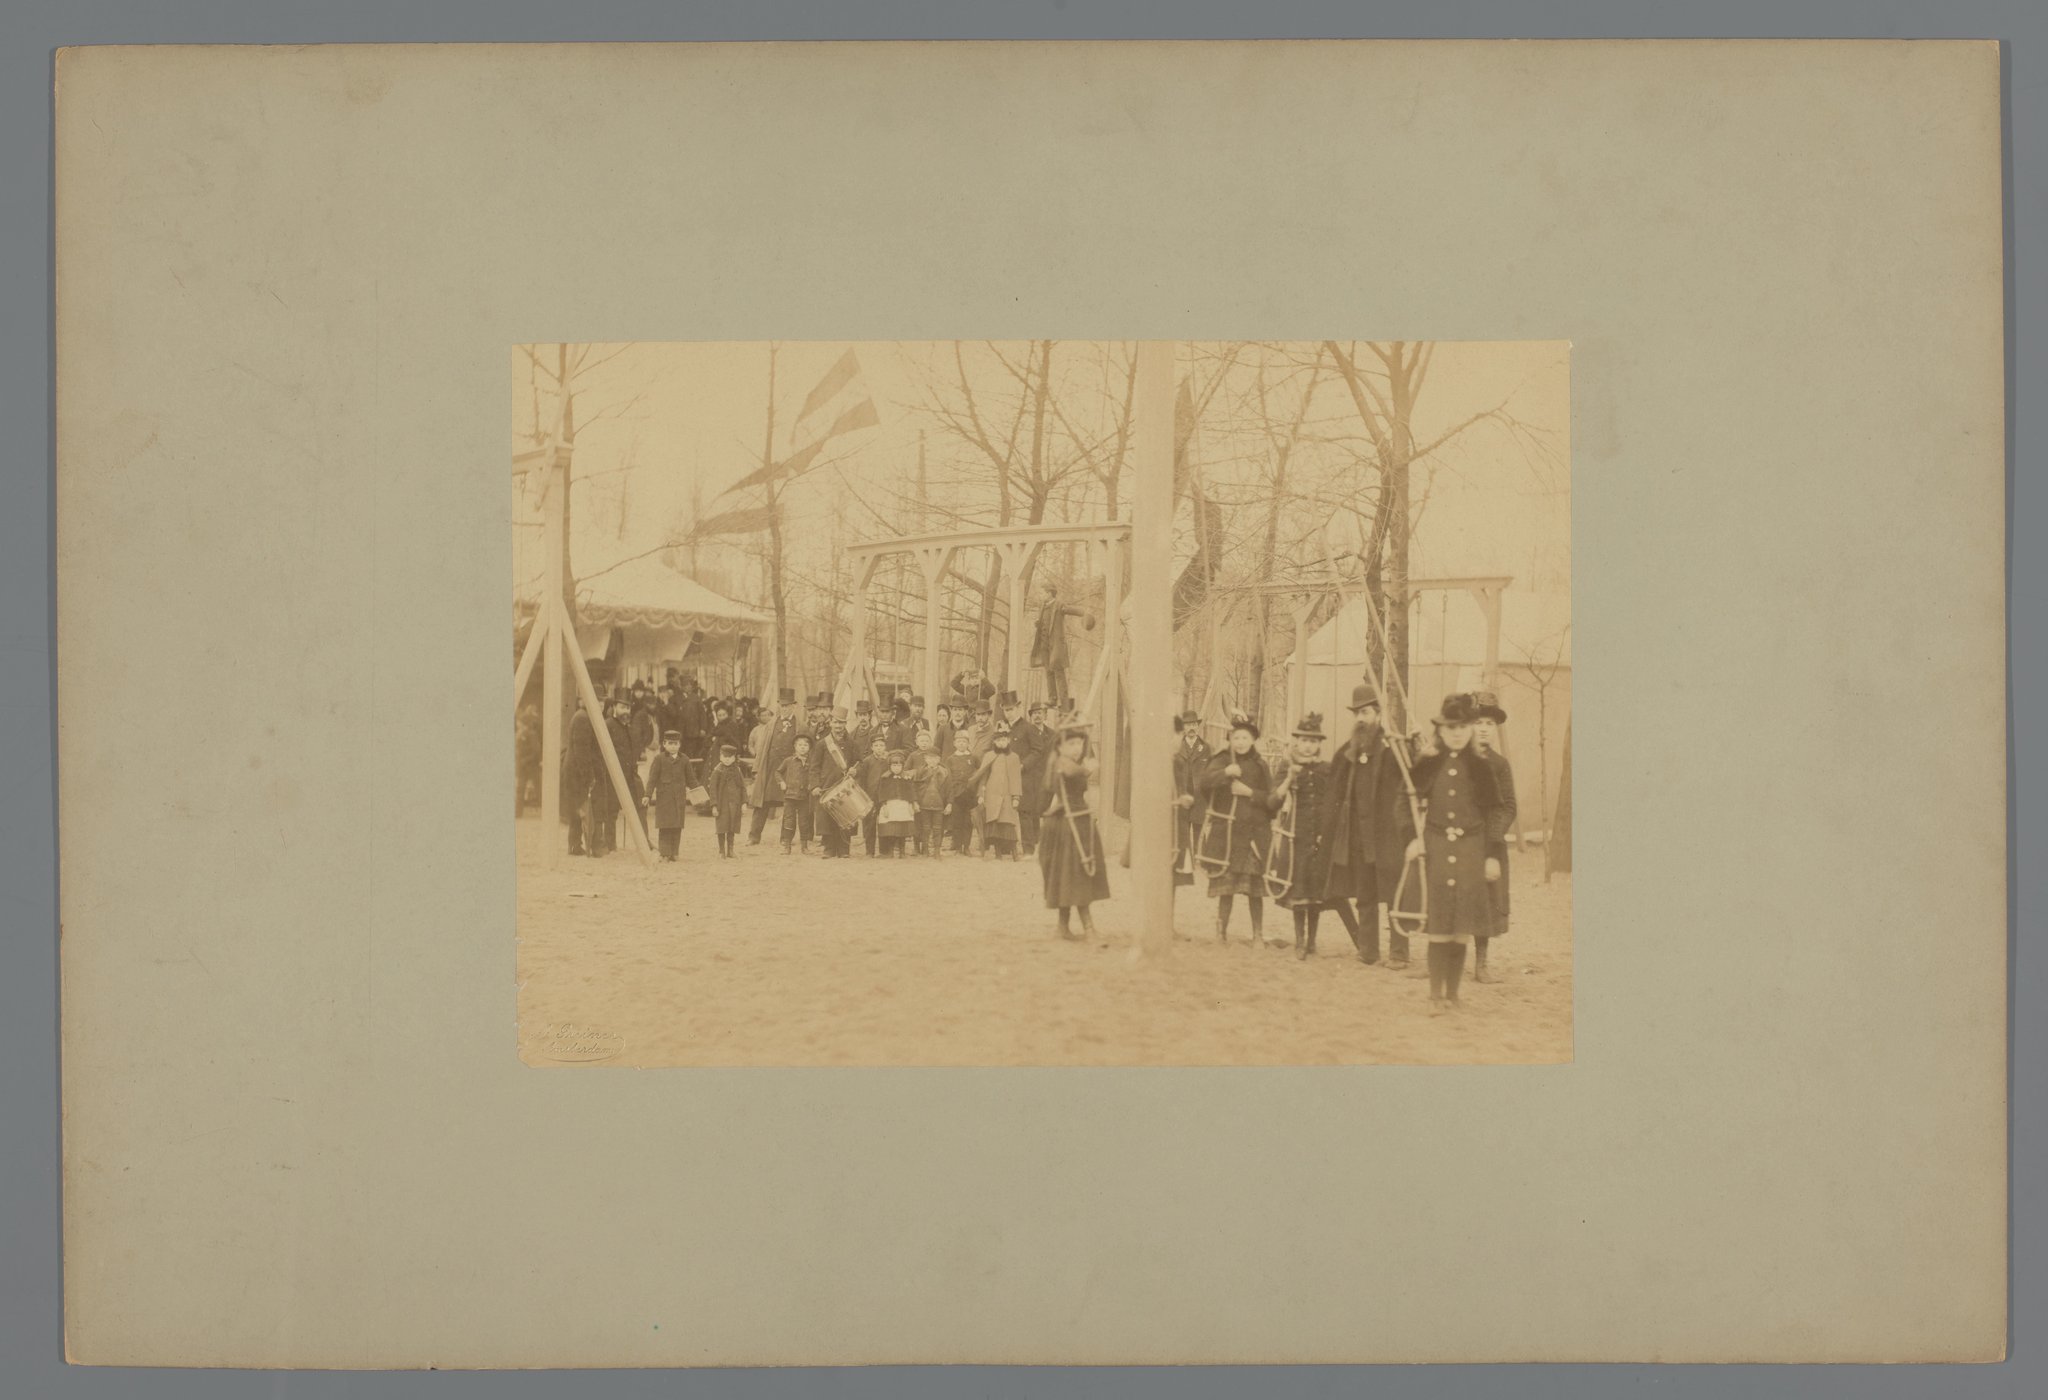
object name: photograph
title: Herinnering Aprilfeesten 1887 Amsterdam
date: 1887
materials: cardboard, paper, photographic support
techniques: albumen print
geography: amsterdam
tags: public festivities on the occasion of royal events, children's games and plays, amsterdam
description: Kinderspelen. Onderdeel van een ensemble bestaande uit zes losse foto's, een titelblad en vijf tekstbladen. Naar aanleiding van de Aprilfeesten gevierd te Amsterdam op 13 april 1887, ter gelegenheid van de 70e verjaardag van koning Willem III. Uitgegeven ten voordele van het Genootschap Liefdadigheid naar Vermogen.